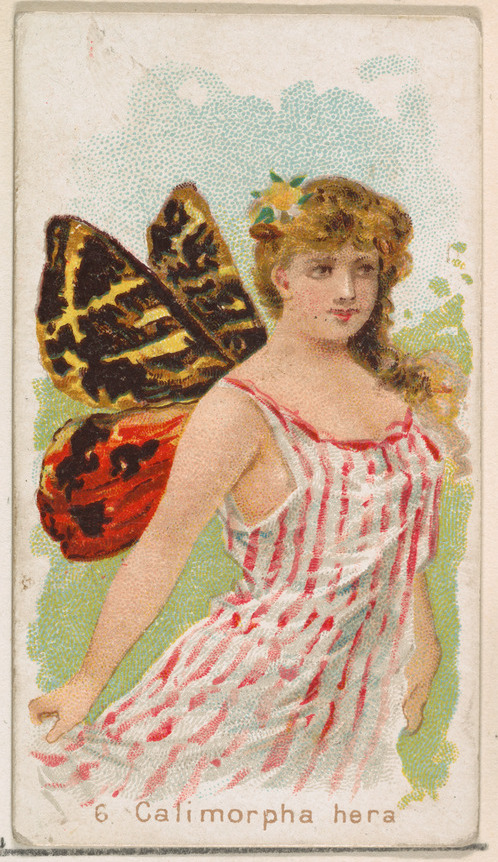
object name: print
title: Card 6, Calimorpha Hera, from the Butterflies series (N183) issued by Wm. S. Kimball & Co.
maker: william s. kimball & company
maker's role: publisher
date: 1888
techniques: color lithograph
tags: women,butterflies